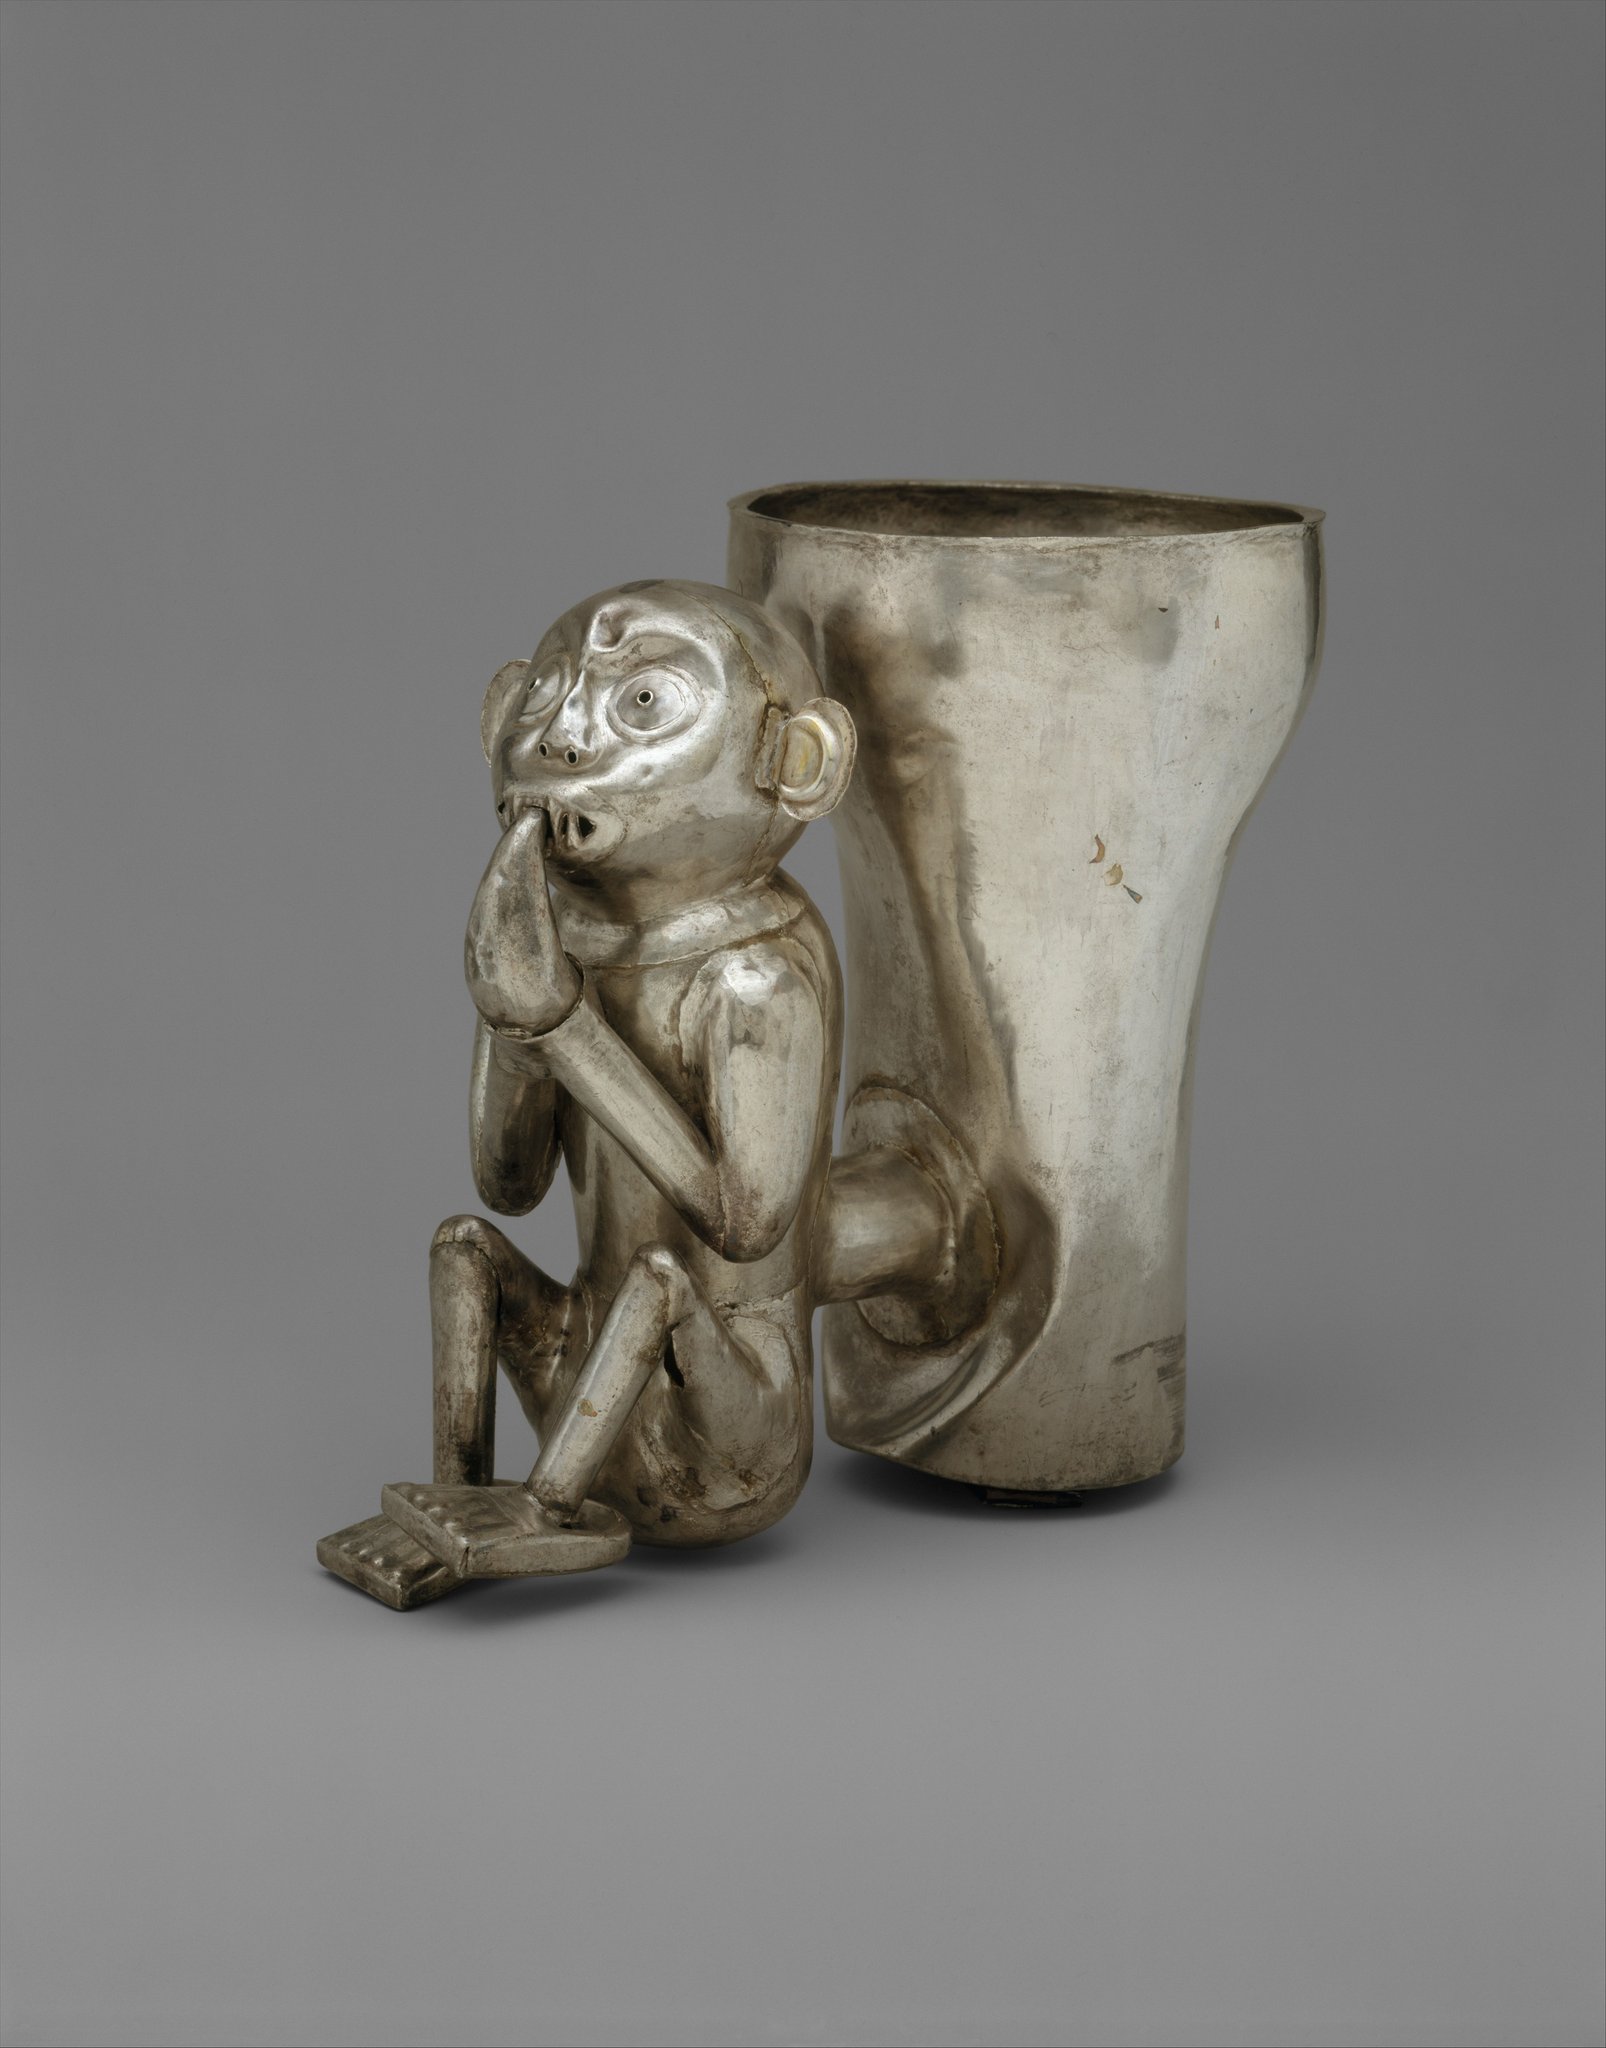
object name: vessel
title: Double-chambered vessel with monkey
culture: chimú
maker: chimú artist(s)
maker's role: artist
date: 1350-1470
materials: silver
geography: peru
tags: monkeys